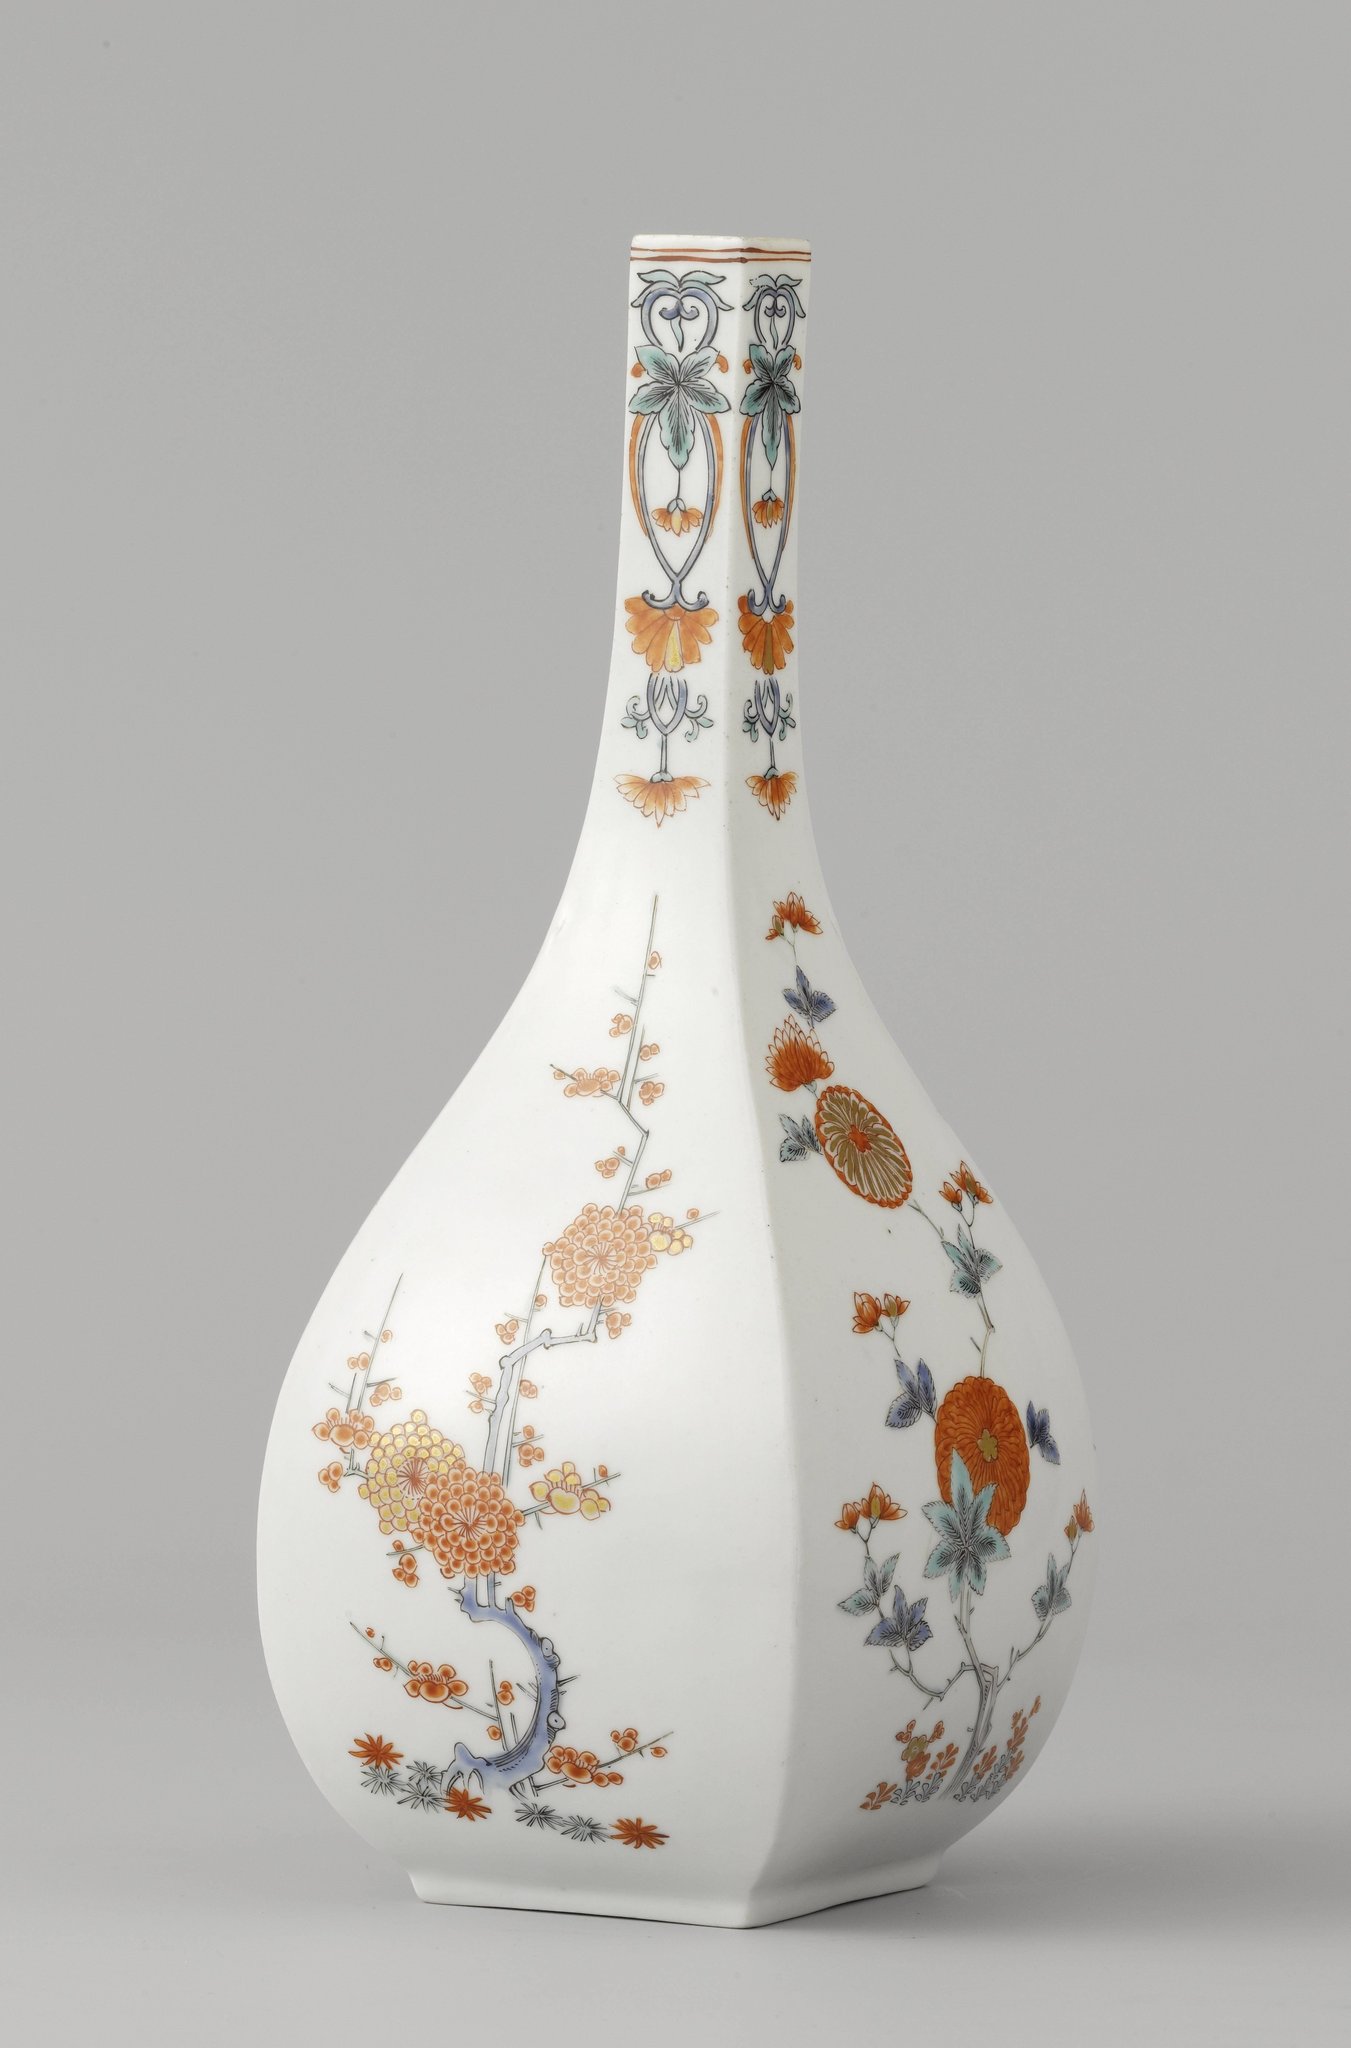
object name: bottle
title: Square bottle with prunus and chrysanthemum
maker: Anonymous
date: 1670-1730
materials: glaze, gold, paint, porcelain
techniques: firing, forming, gilding, turning, vitrification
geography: japan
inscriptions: label: ‘Collectie Westendorp/ 122’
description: The practice of embellishing undecorated Asian porcelain in Europe was not uncommon. This bottle is painted in a Kakiemon style, which may have actually been executed in Meissen.